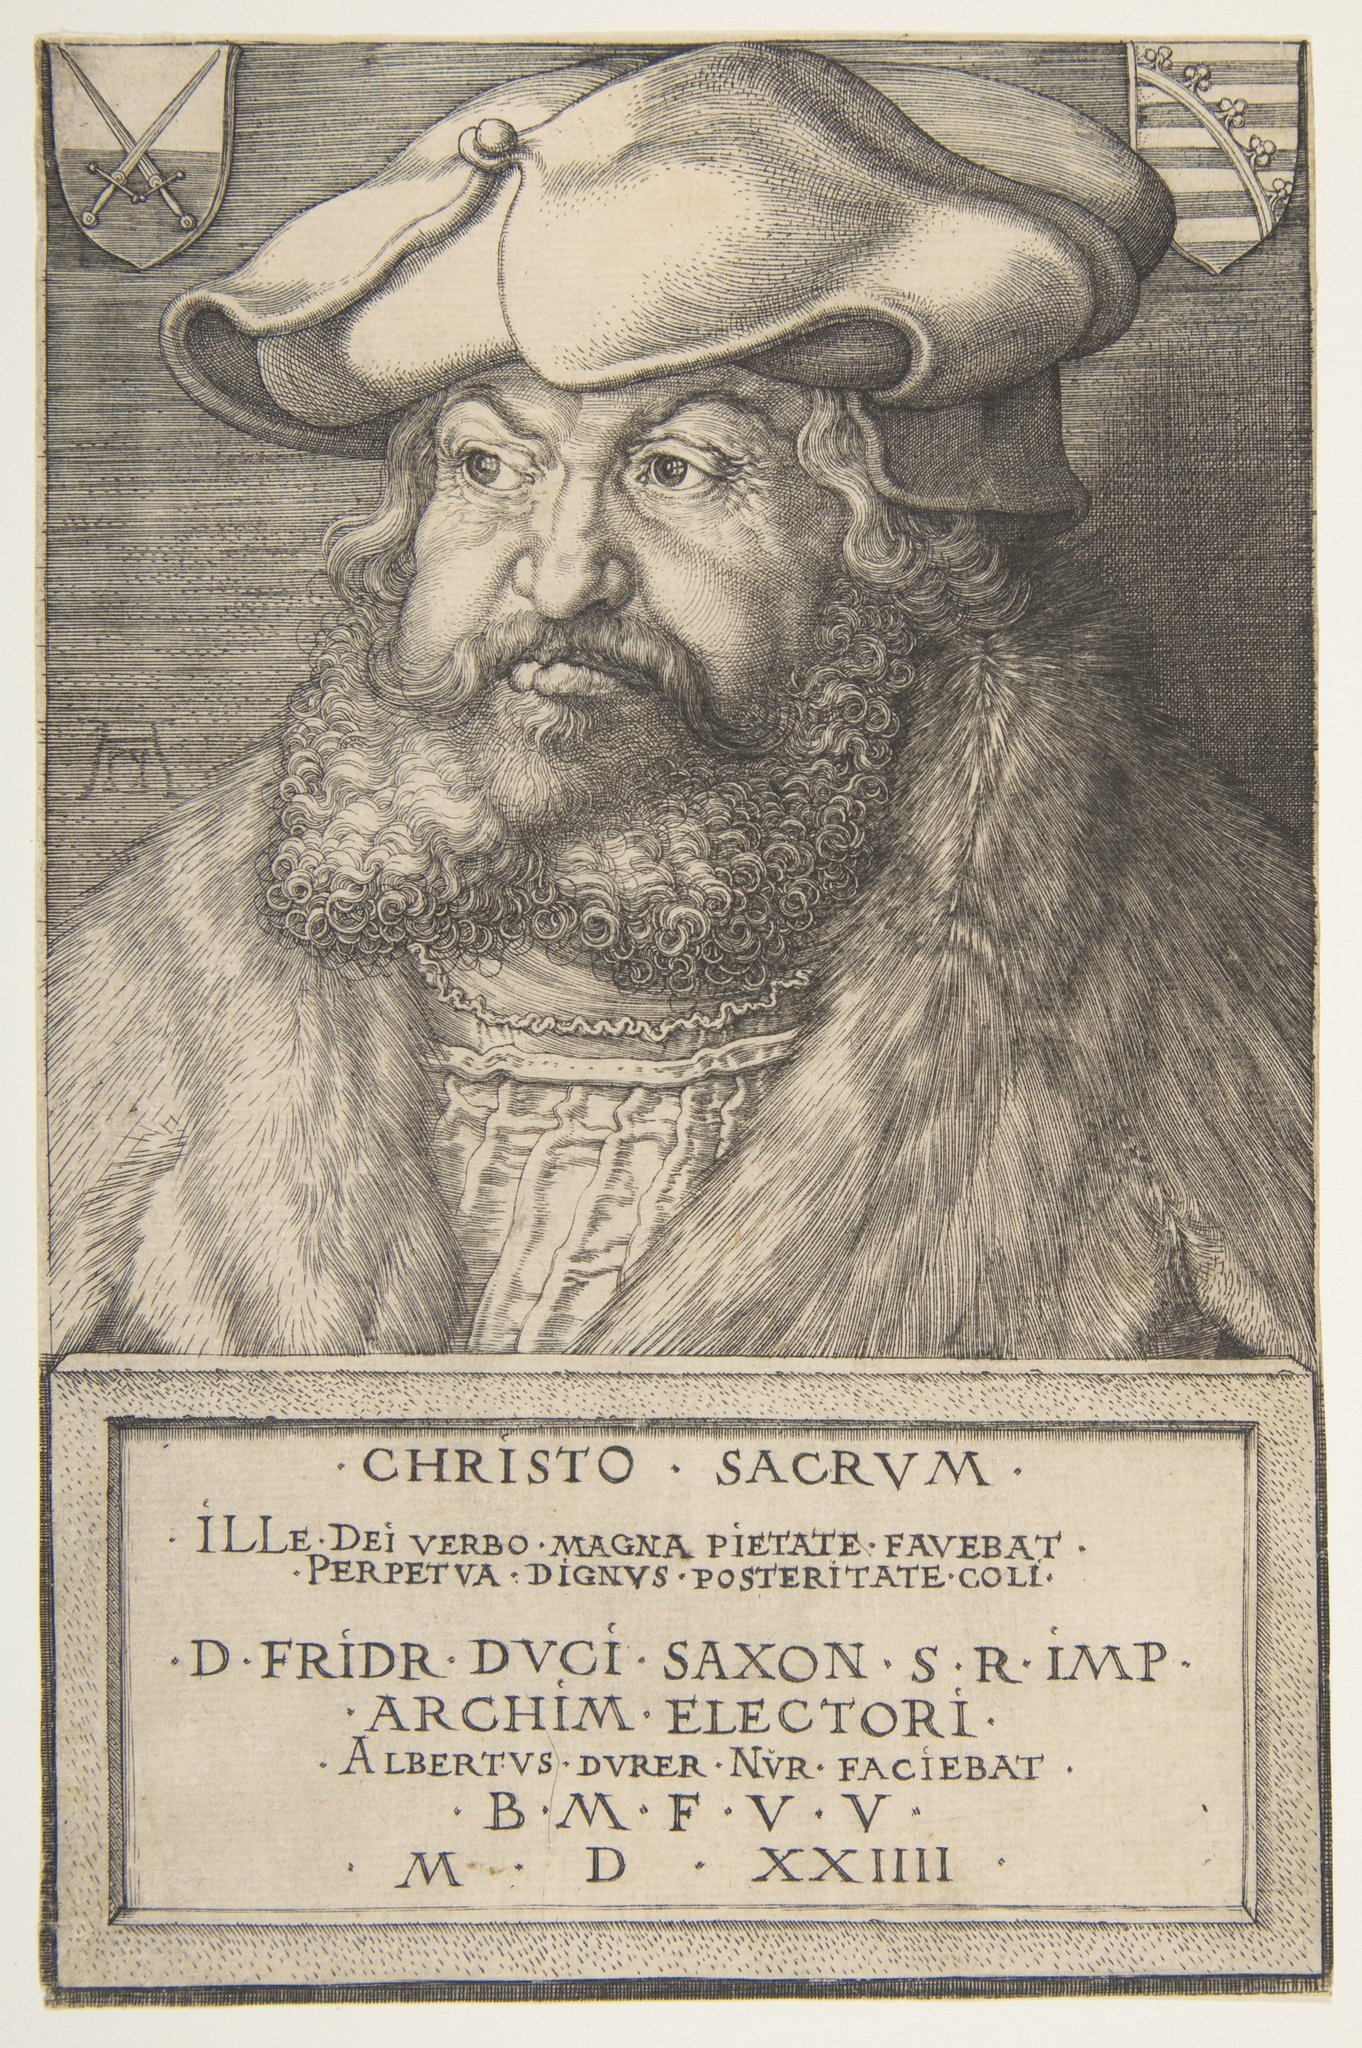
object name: print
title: Frederick the Wise, Elector of Saxony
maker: albrecht dürer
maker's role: artist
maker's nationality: german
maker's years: 1471-1528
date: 1524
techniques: engraving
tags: men,portraits,coat of arms